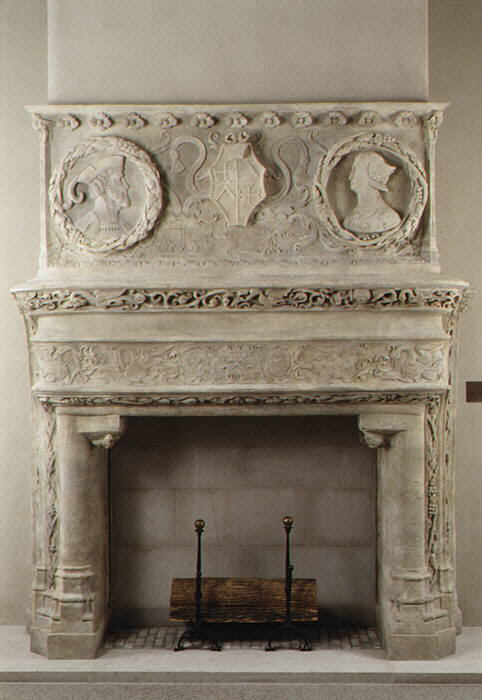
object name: mantelpiece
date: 1515-1520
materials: limestone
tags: birds,men,profiles,women,coat of arms